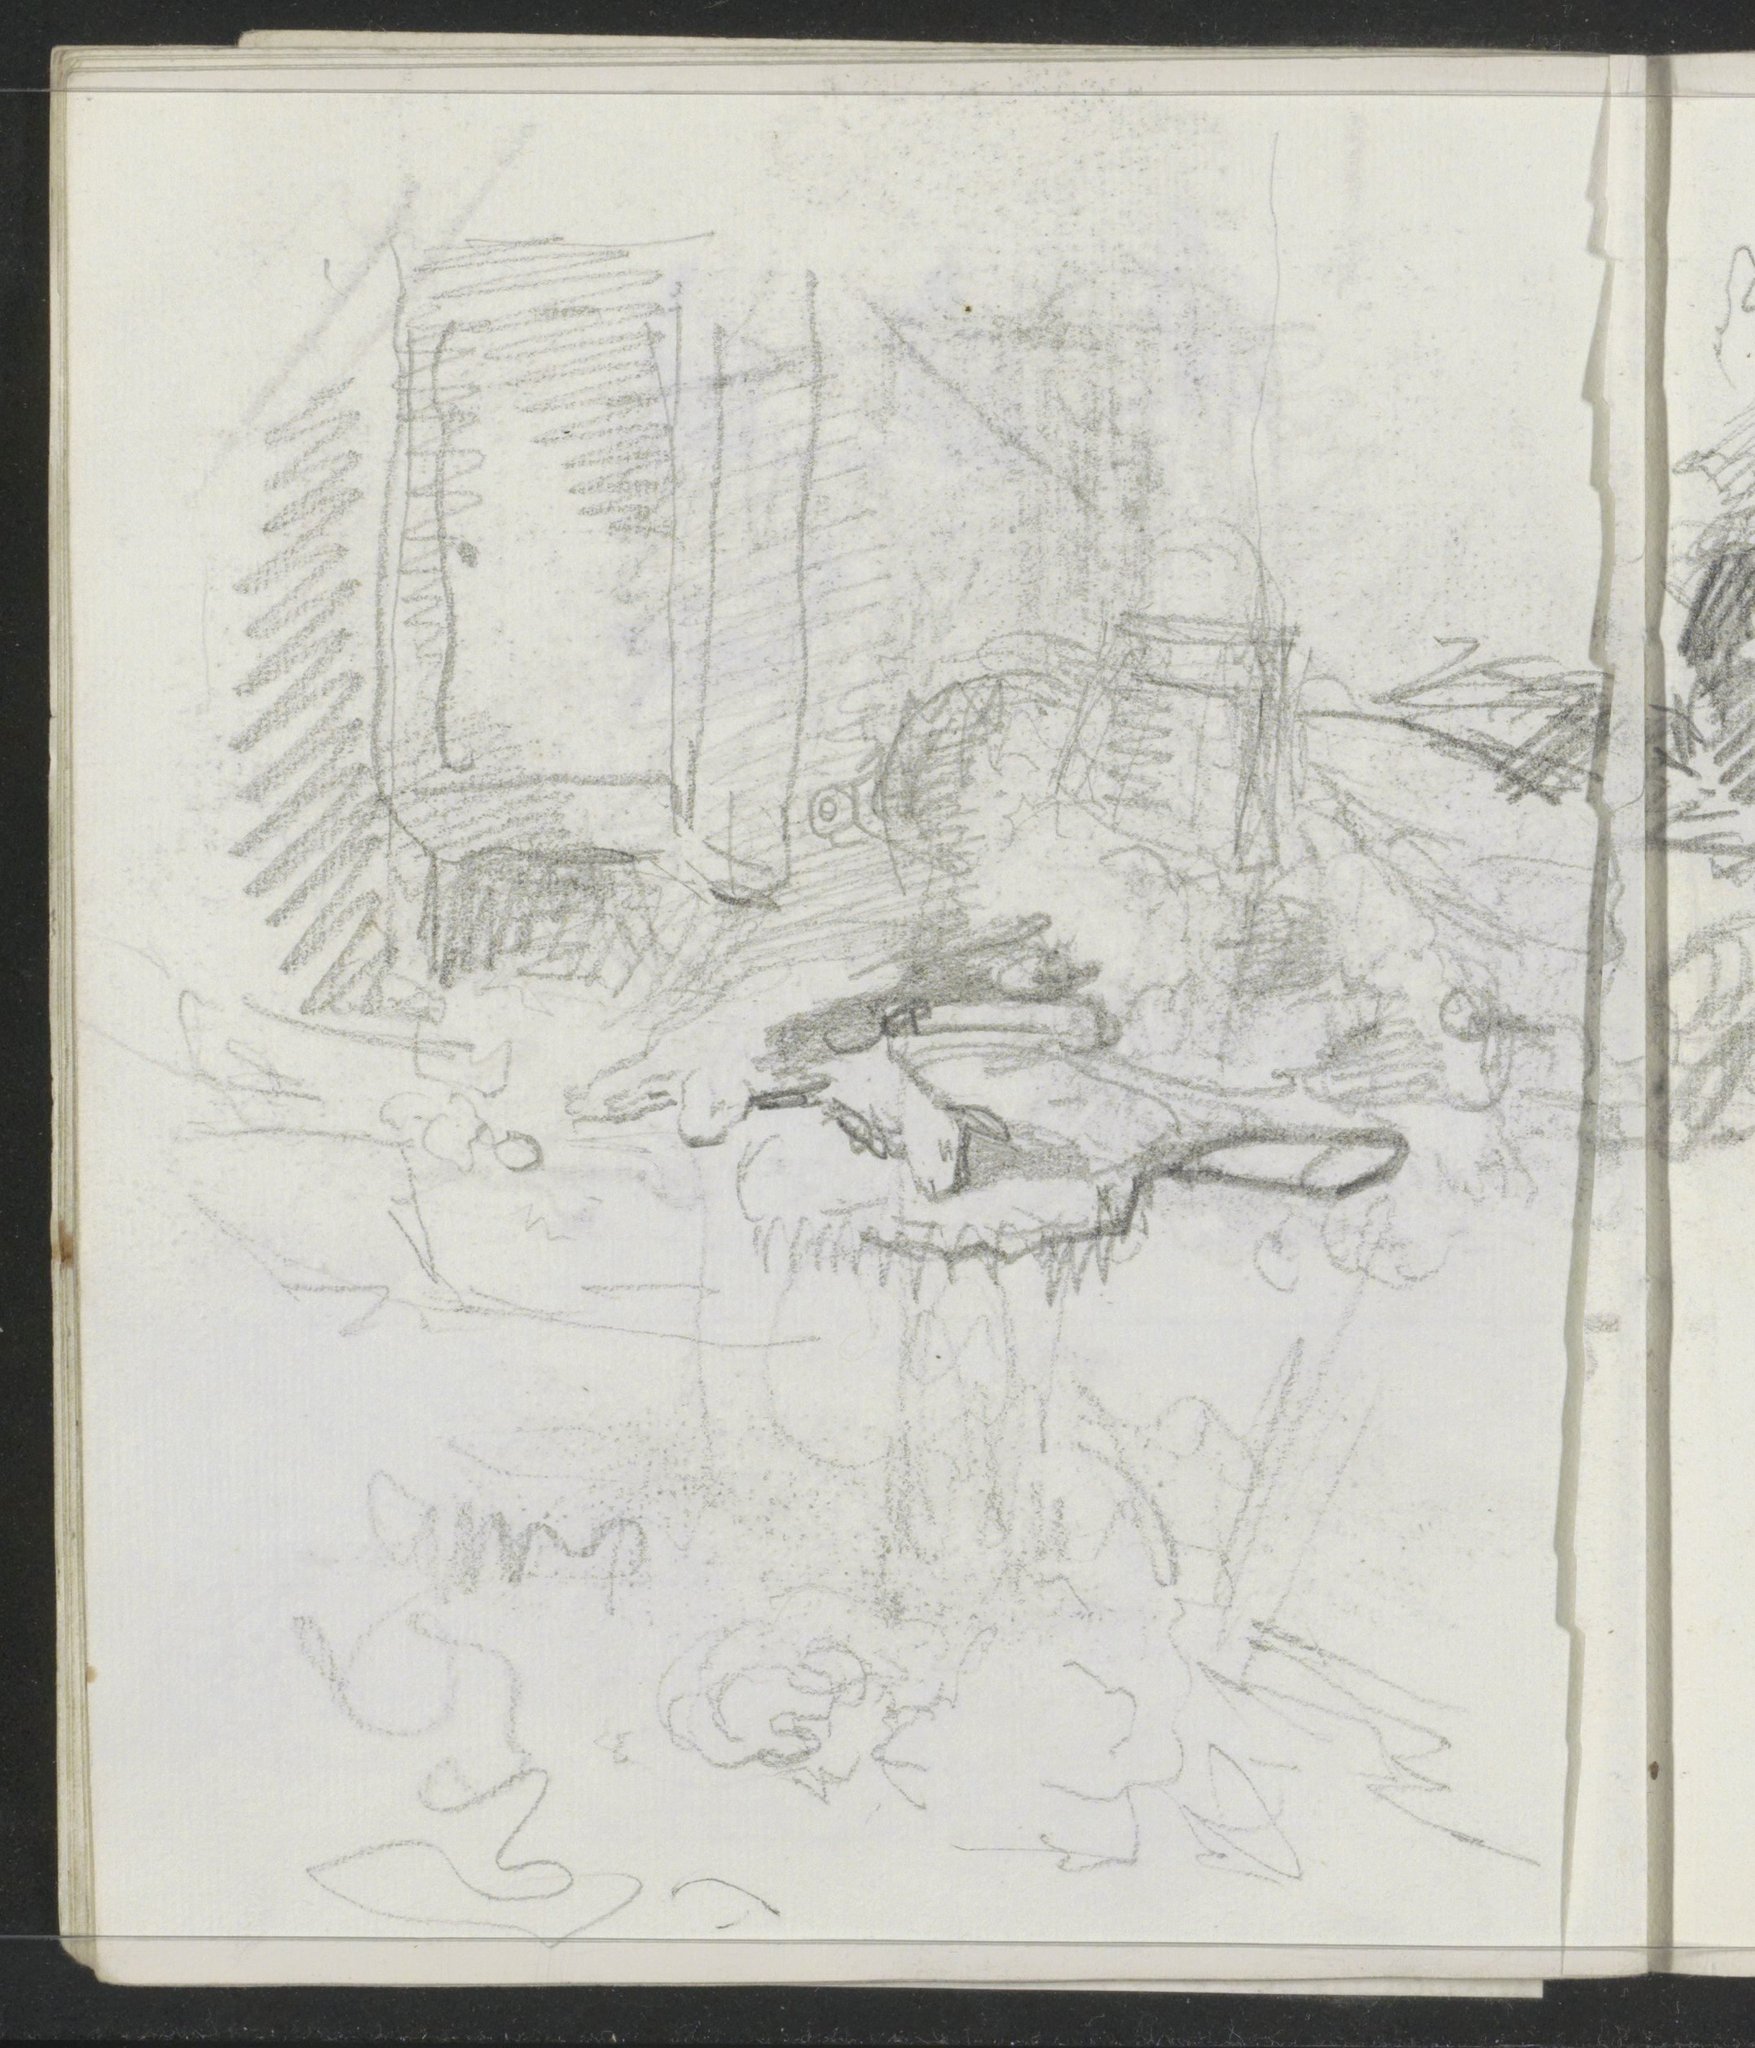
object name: sketchbook leaf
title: Studie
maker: maria vos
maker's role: draughtsman, painter, print maker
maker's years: 1824-1906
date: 1834-1906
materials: paper, pencil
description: Blad 14 verso uit een schetsboek met 20 bladen.